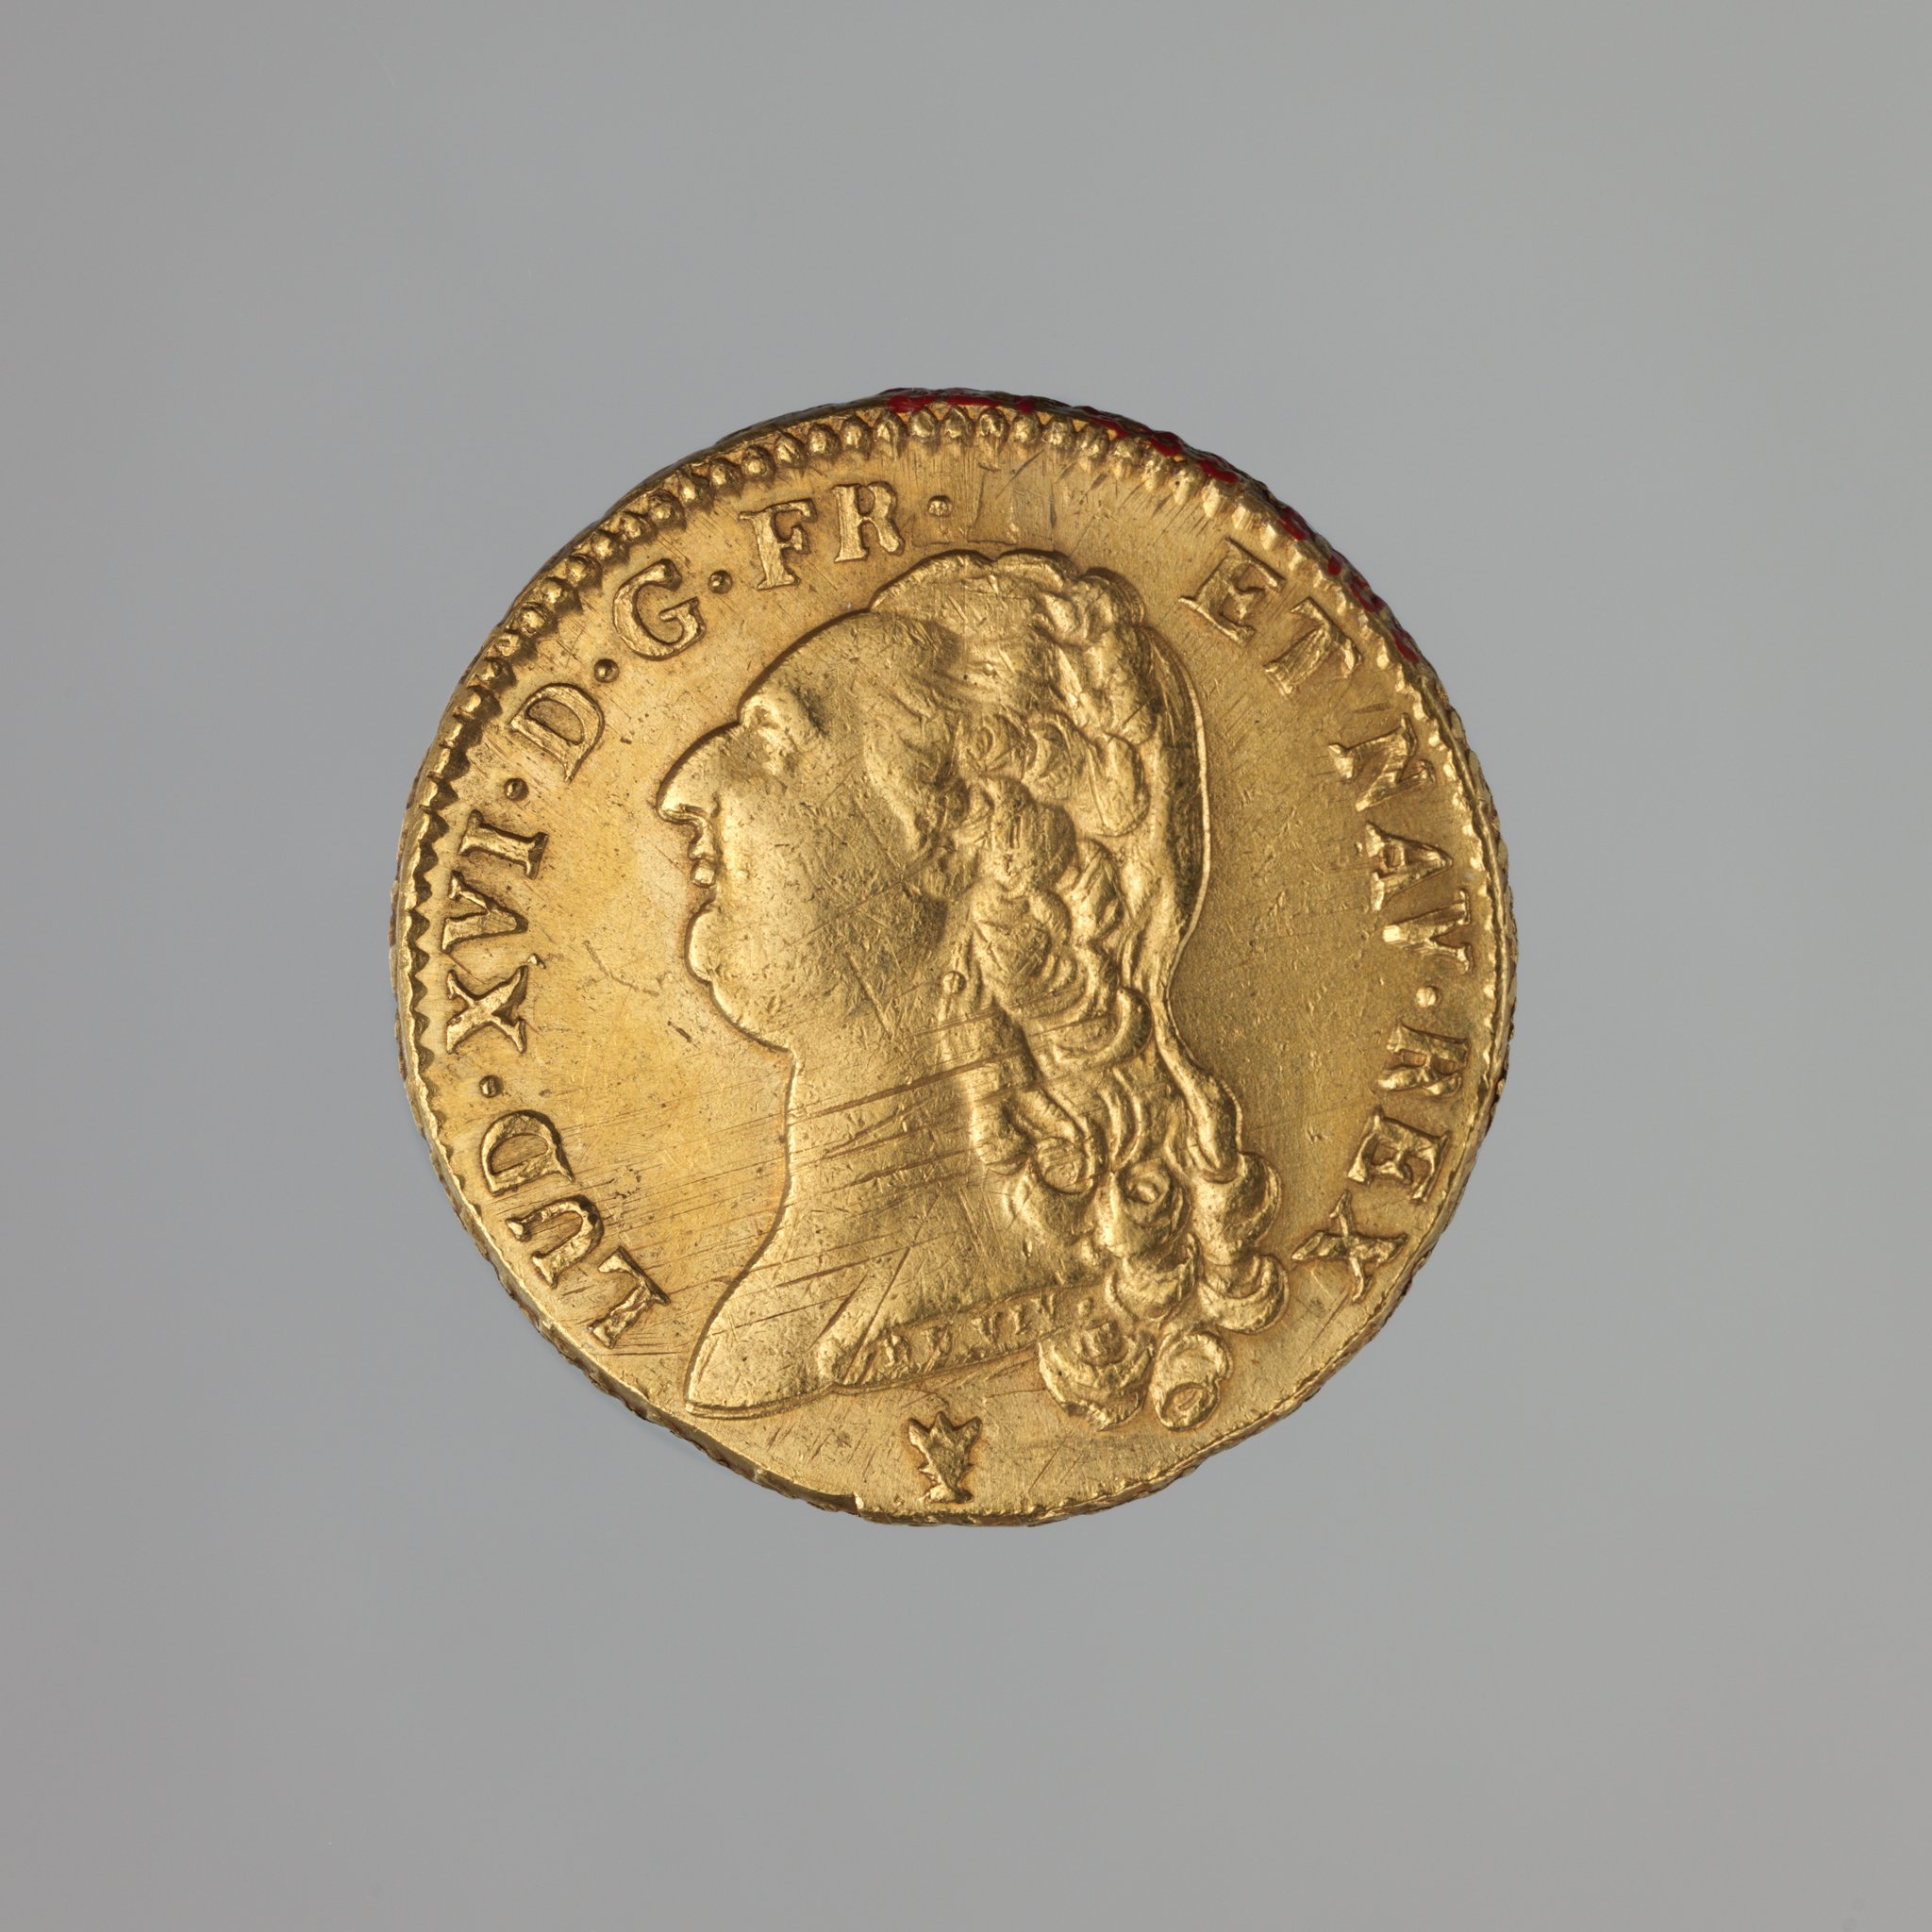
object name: coin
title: Double Louis d’or of Louis XVI of France (b. 1754-93; r. 1774–1792)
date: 1786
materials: gold